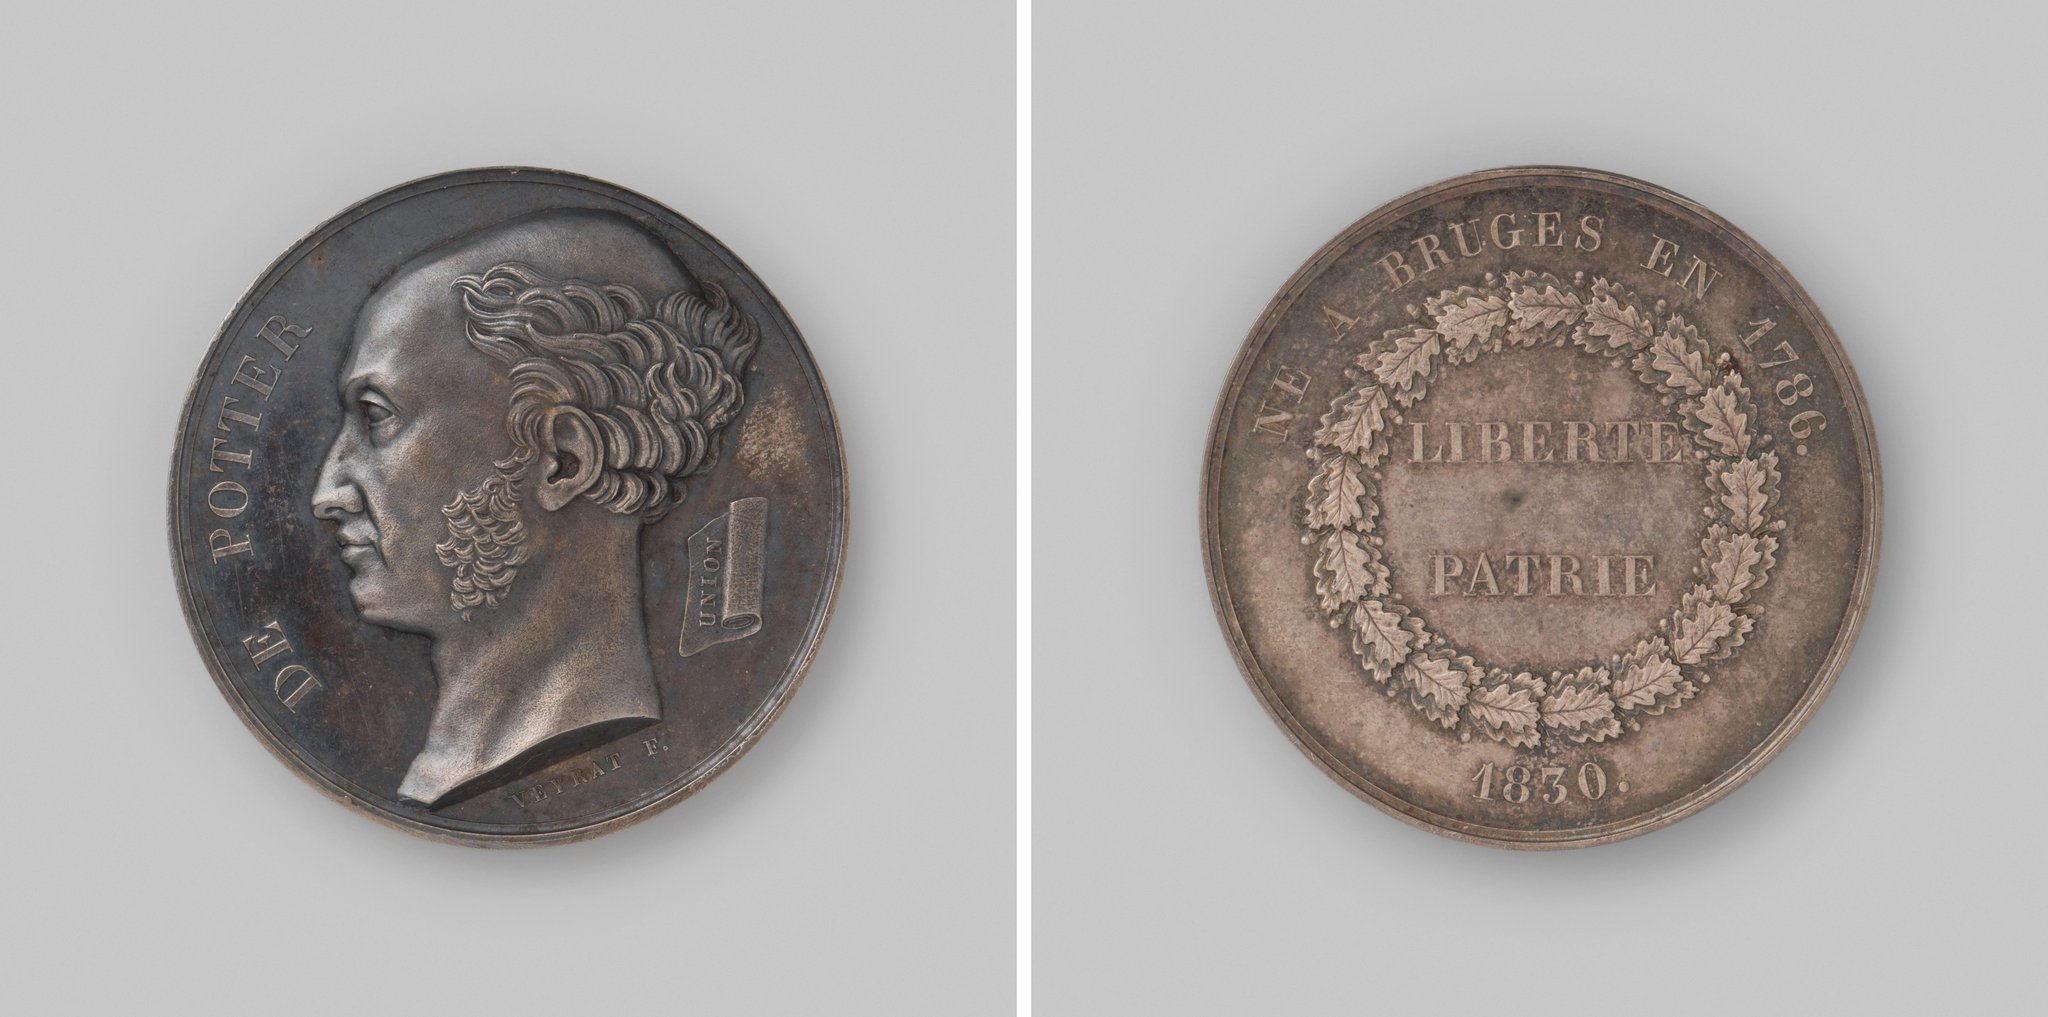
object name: history medal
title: Louis Joseph de Potter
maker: adrien hippolyte veyrat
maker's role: medailleur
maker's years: 1803-1883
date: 1830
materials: silver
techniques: striking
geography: brussels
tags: bruges, politician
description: Zilveren penning. Voorzijde: borststuk man; rechts daarvan een voor de helft ontrold papier met opschrift binnen omschrift. Keerzijde: opschrift binnen eikenkrans en omschrift.